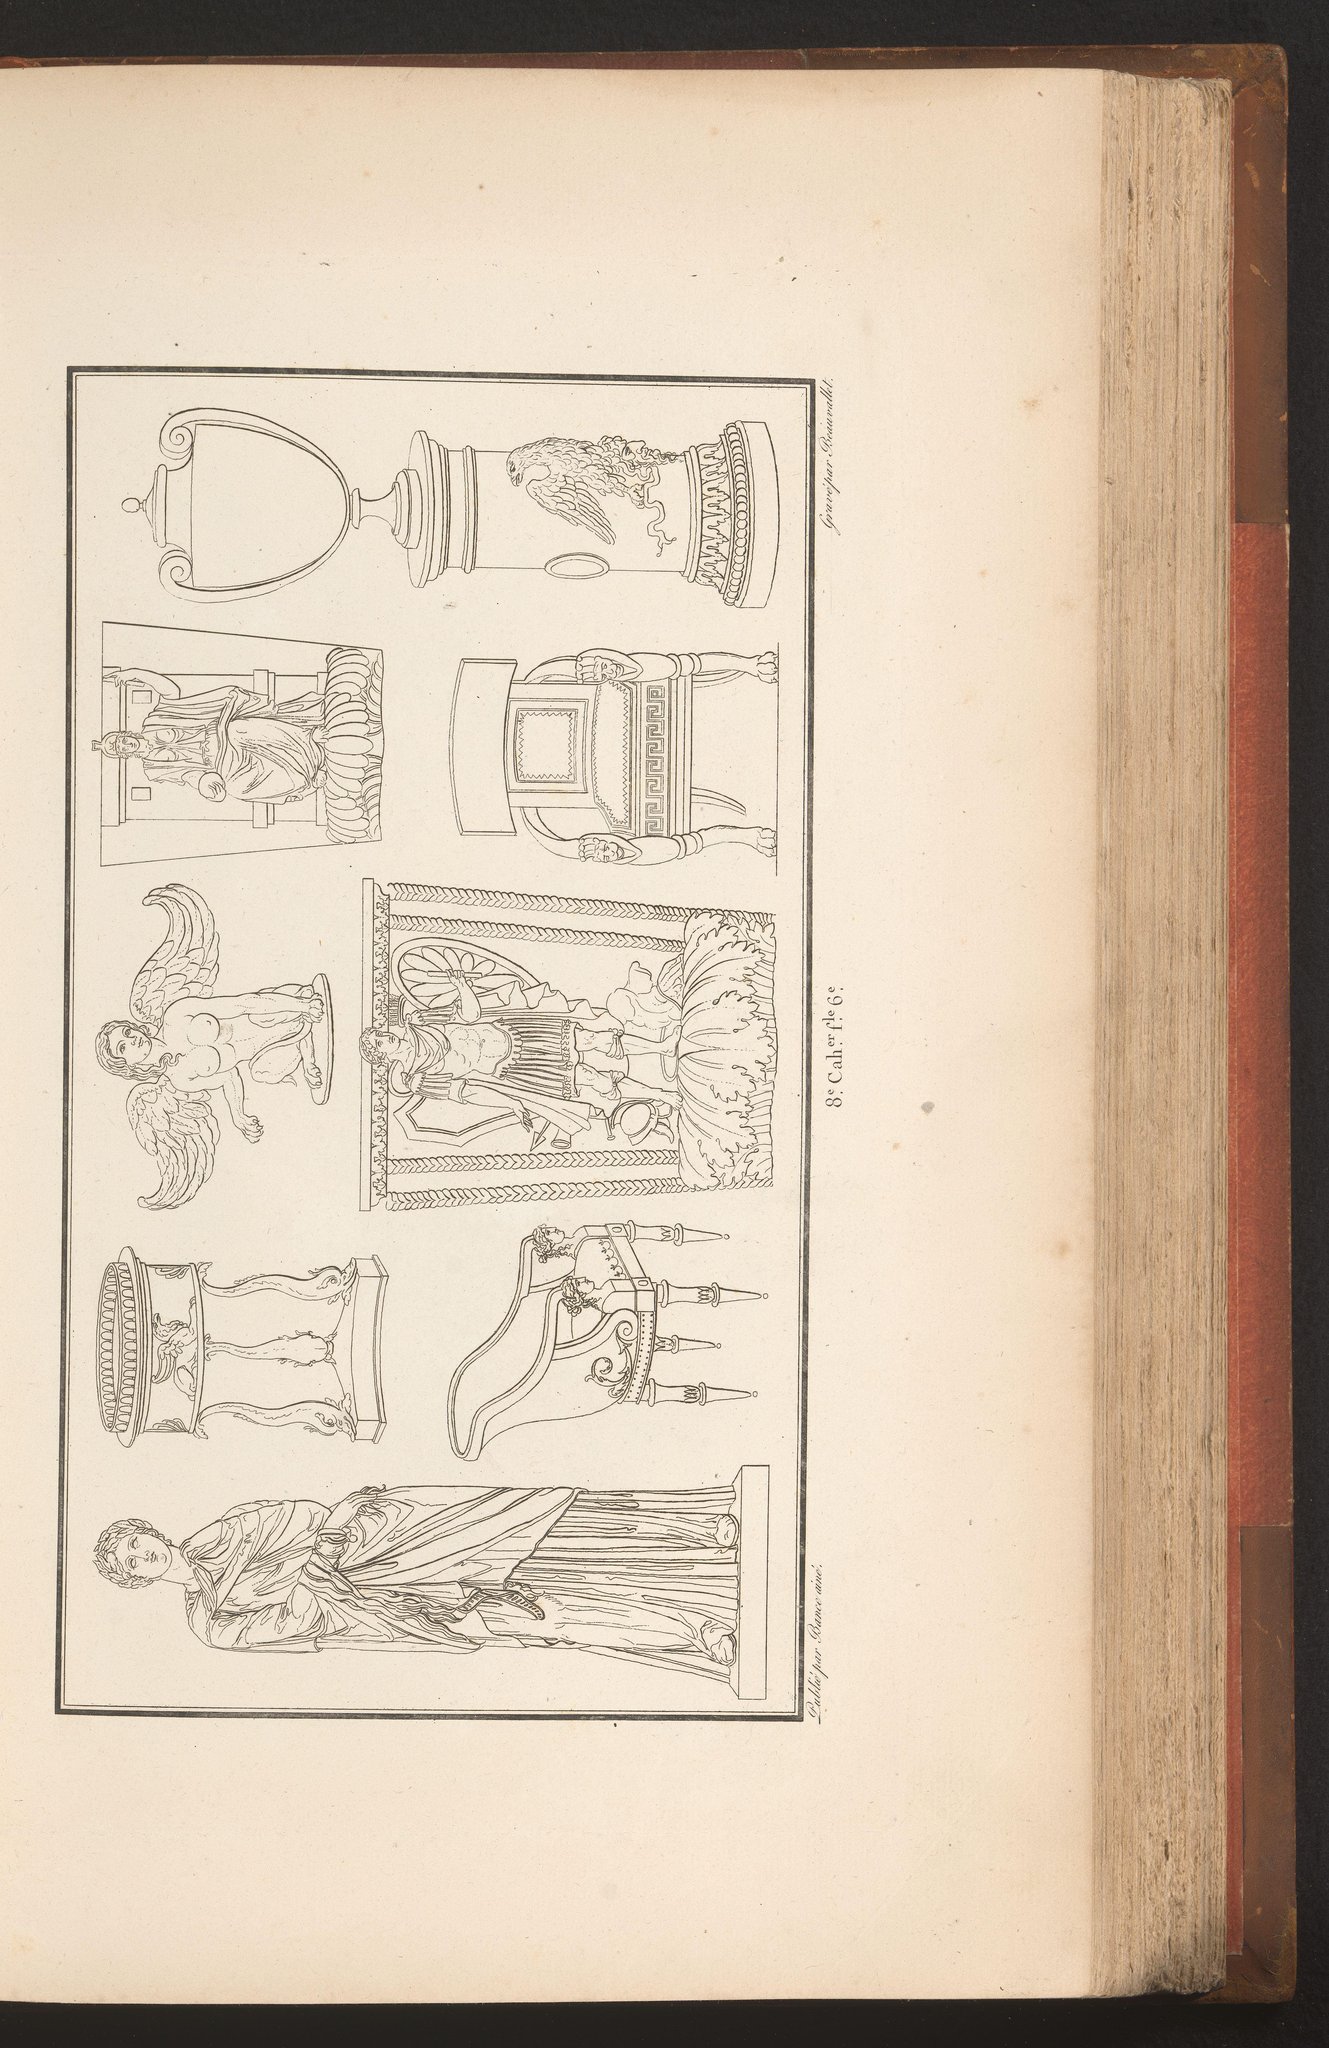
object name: ornament print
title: Diverse ornamenten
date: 1820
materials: paper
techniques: etching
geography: paris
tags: ornaments ~ art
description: Ornamentprent met diverse objecten, links een staande figuur, rechts een vaas op een voetstuk. Onderdeel (8e. Cah. f.le 6) van het prentalbum met twee series van in totaal 138 ornamentprenten door Beauvallet en Normand, 'Fragmens d'Ornemens dans le Style Antique'.